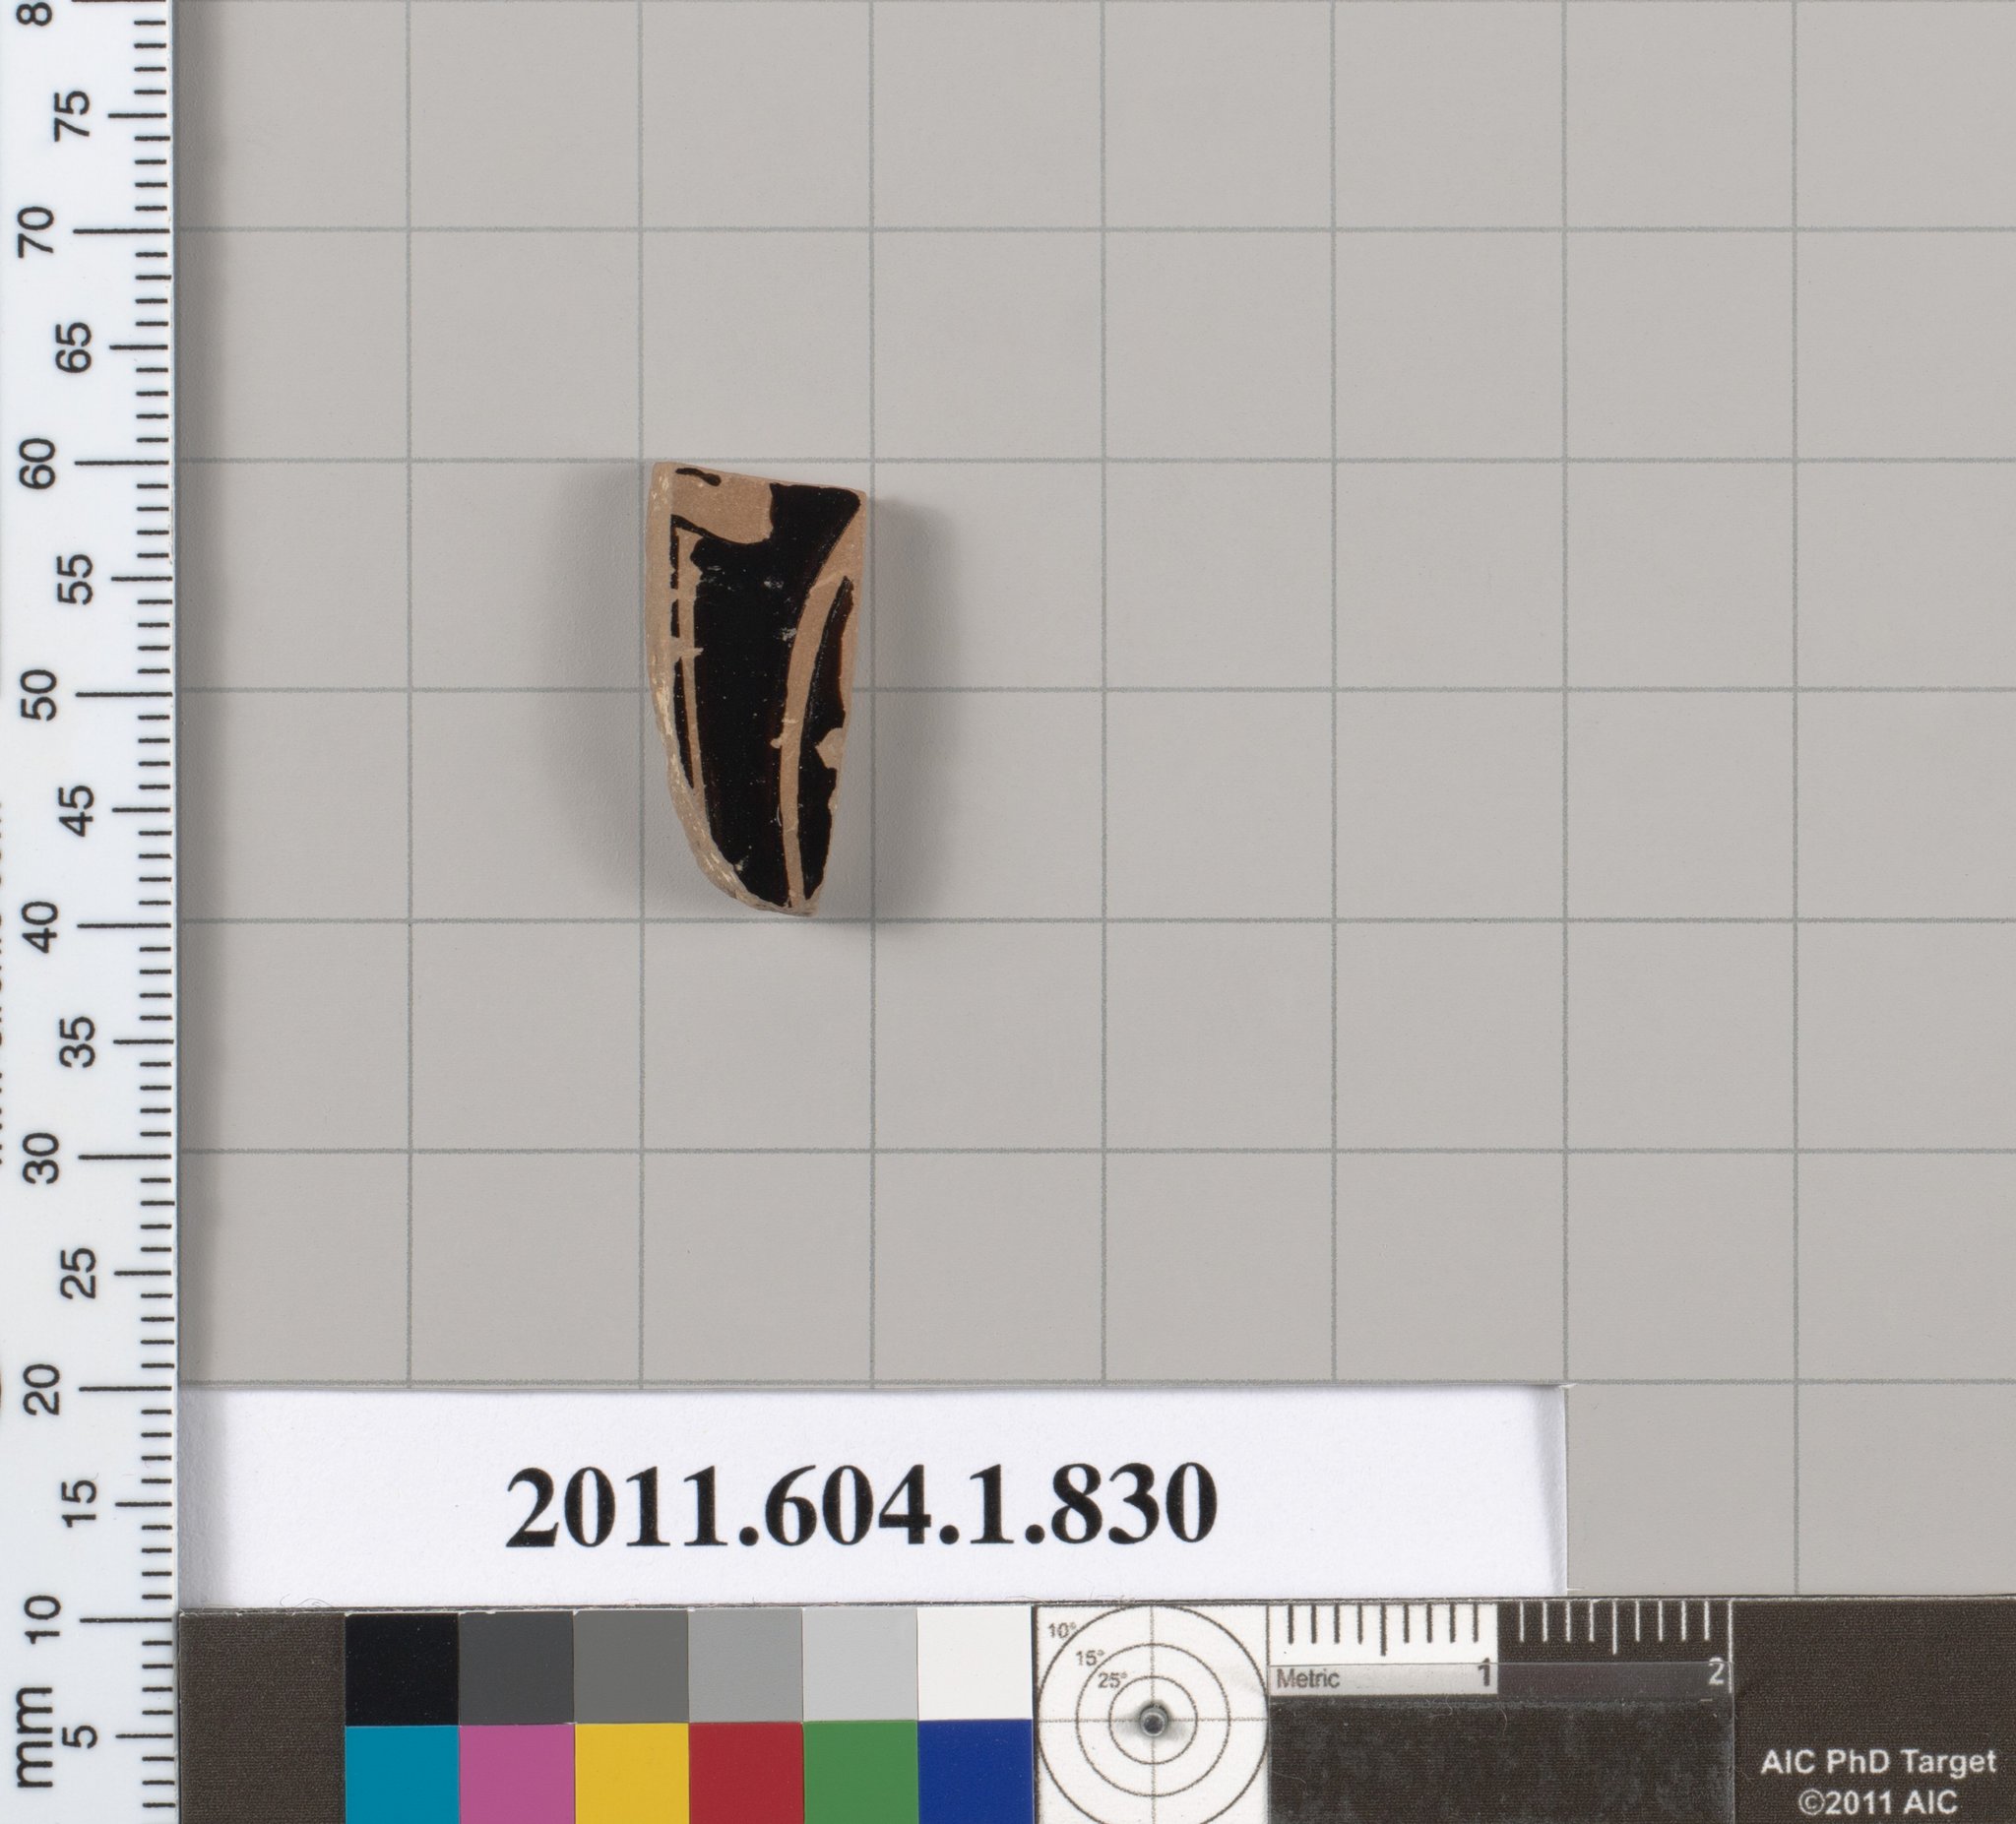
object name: kylix fragment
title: Terracotta fragment of a kylix (drinking cup)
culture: greek, attic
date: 500-476 BCE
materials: terracotta